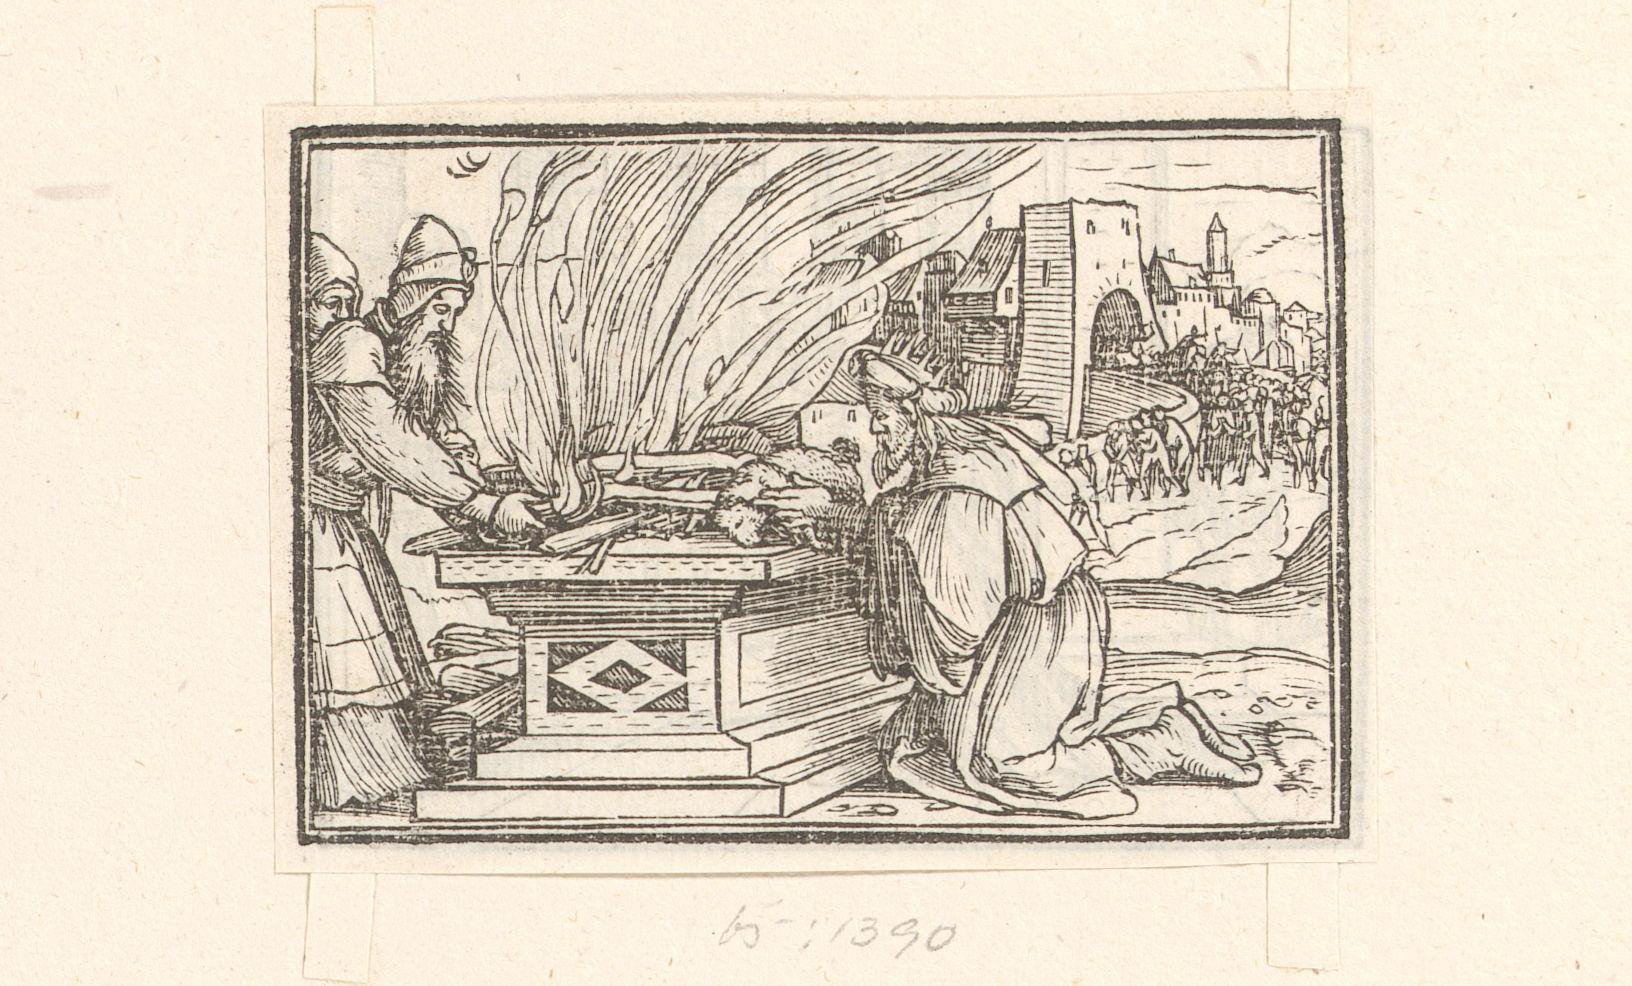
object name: album leaf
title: Heidens offer van koning Achaz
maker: veit rudolf specklin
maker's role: print maker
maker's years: -1550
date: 1538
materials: paper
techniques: woodcut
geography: switzerland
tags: ahaz' apostasy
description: Boekillustratie voor het eerst gebruikt in: Biblia Utriusque Testamenti iuxta Vulgatam Translationem, Lyon, M. en G. Trechsel (voor Hugo à Porta) 1538. Later in verschillende uitgaven opnieuw gebruikt. Deze prent vermoedelijk gebruikt in één van de uitgaven uitgegeven en/of gedrukt door Jean Frellon, Lyon.